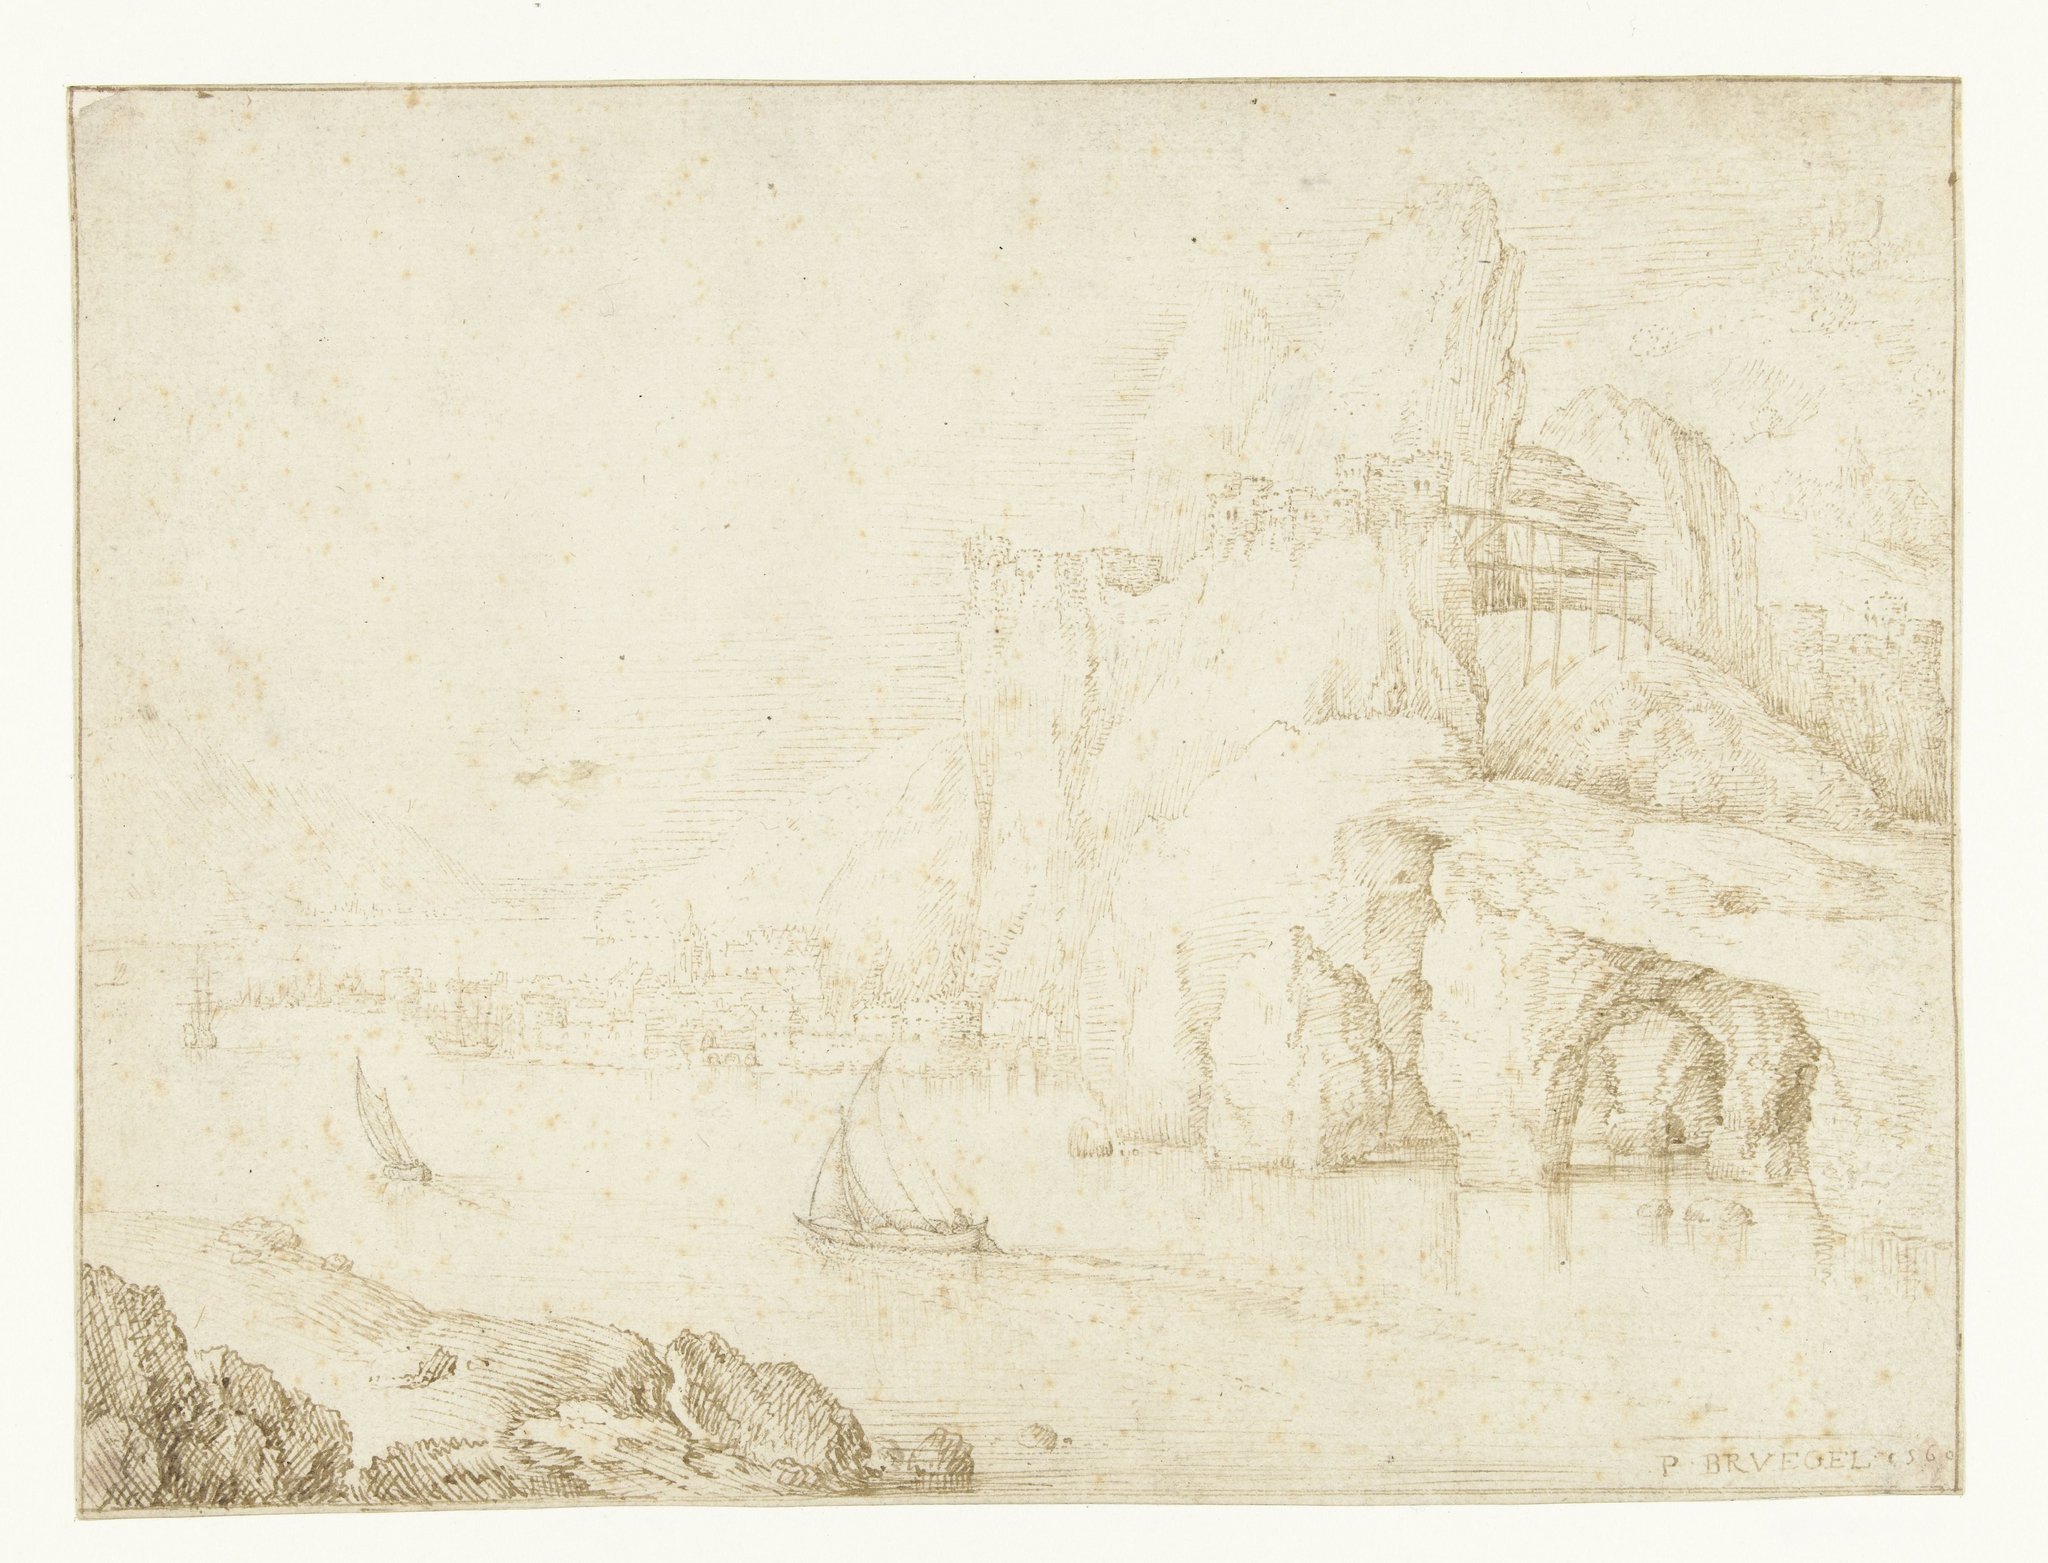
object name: drawing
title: Stad met hoge rotsen gelegen aan een rivier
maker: pieter bruegel (i)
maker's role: draughtsman, print maker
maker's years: 1525-1569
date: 1560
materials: ink, paper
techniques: pen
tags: river, rocks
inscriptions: date